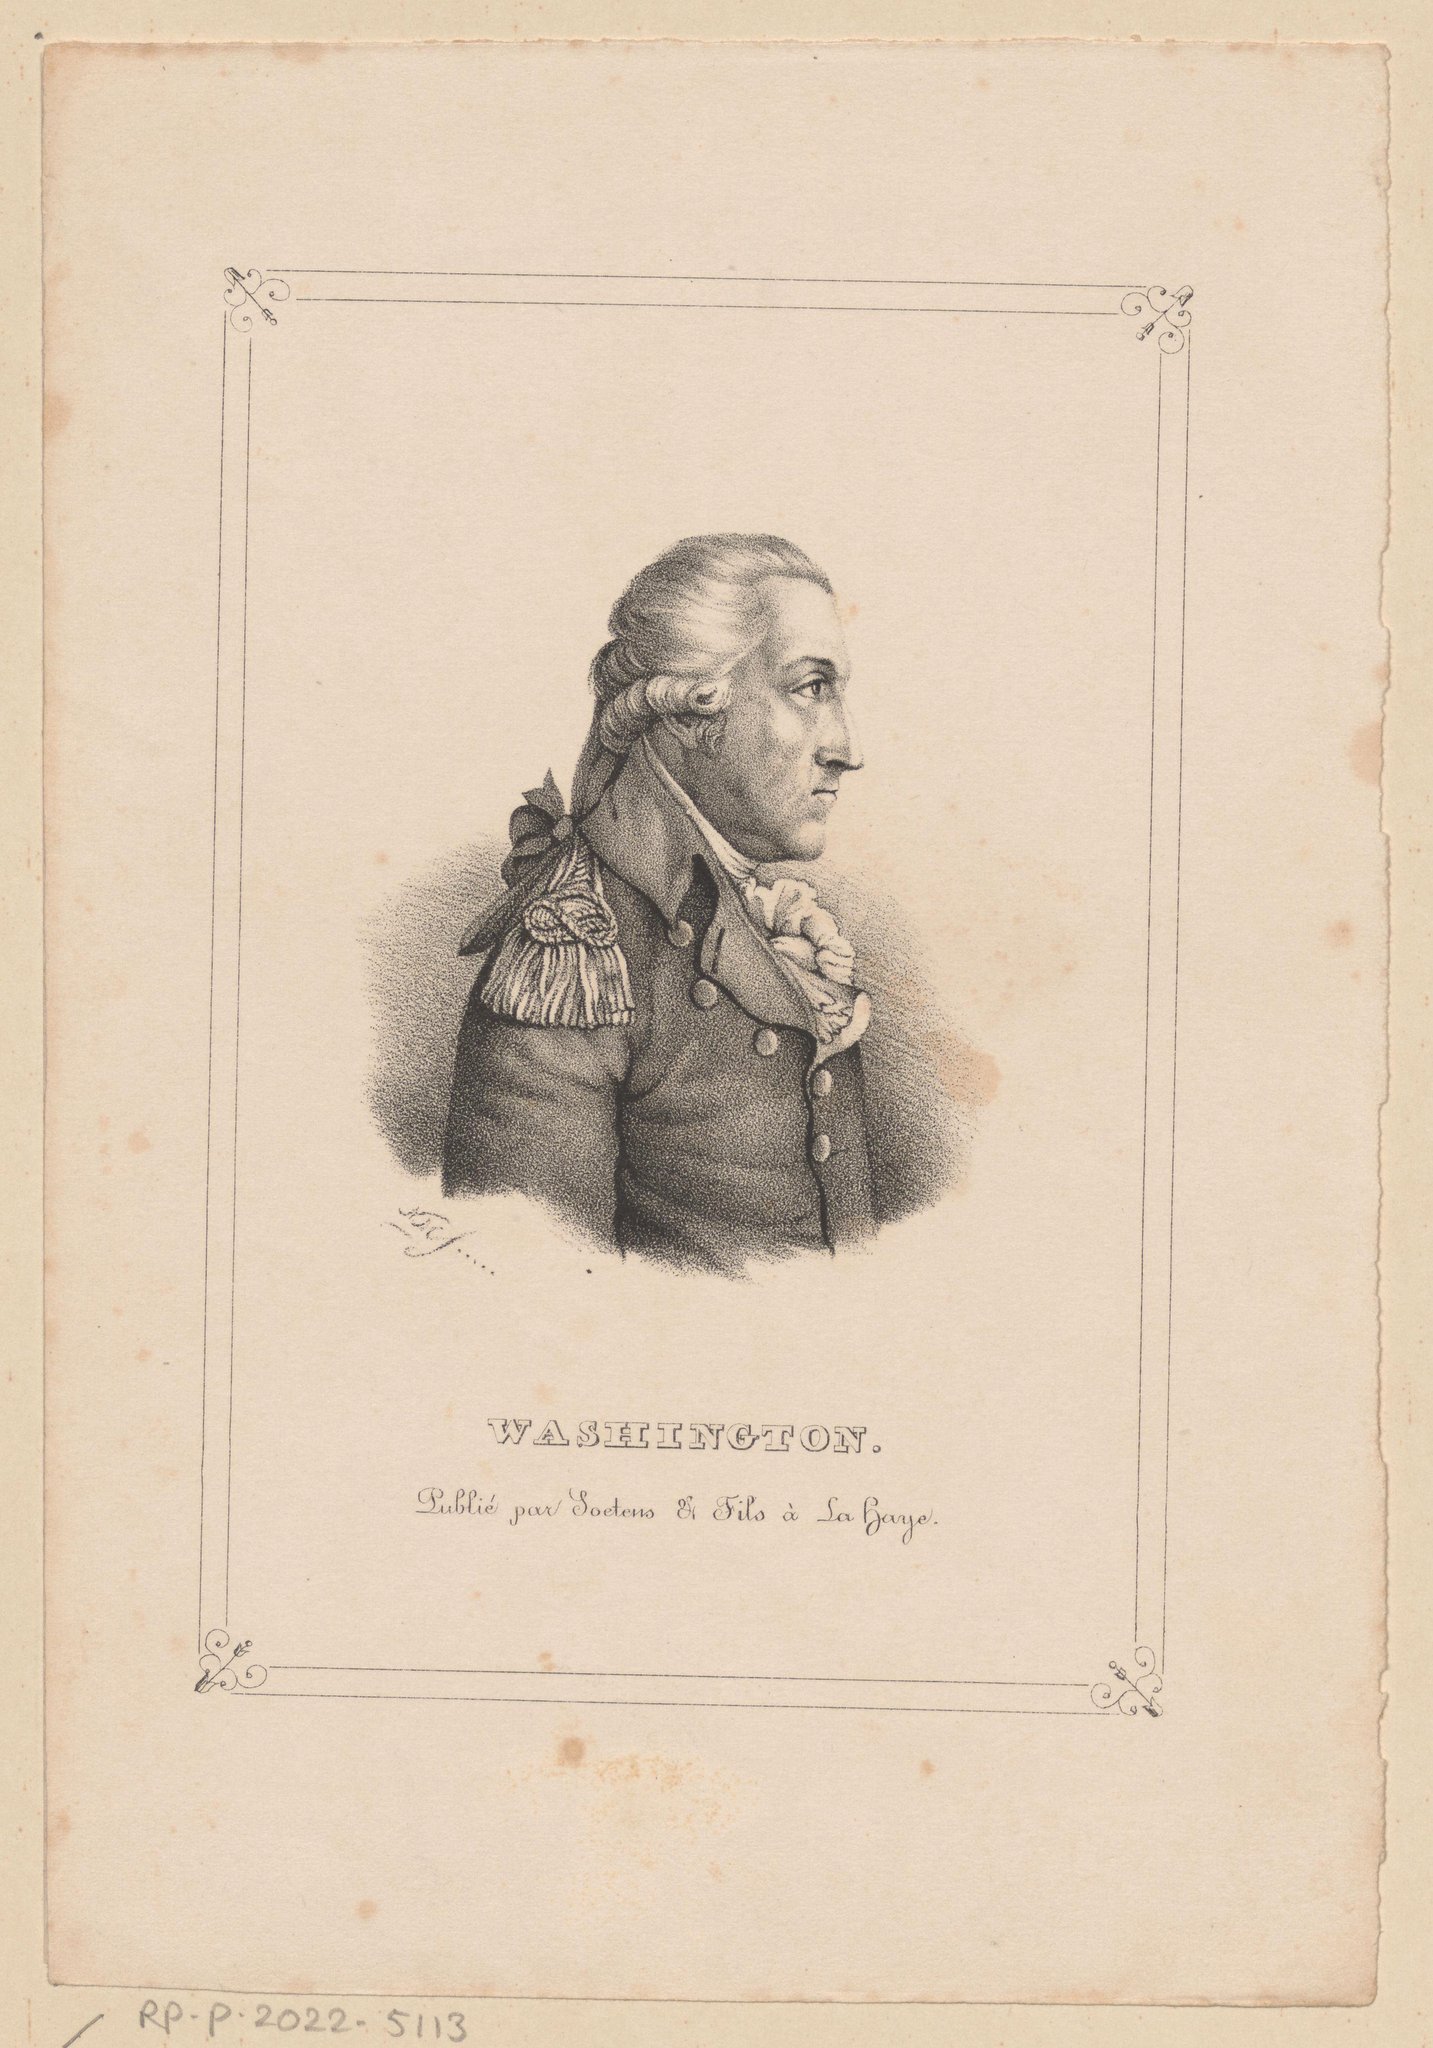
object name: print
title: Portret van George Washington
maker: nicolaas martinus schild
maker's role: draughtsman, print maker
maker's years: 1822-1840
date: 1836-1840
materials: paper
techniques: lithograph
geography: the hague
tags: president ~ head of republic, historical persons